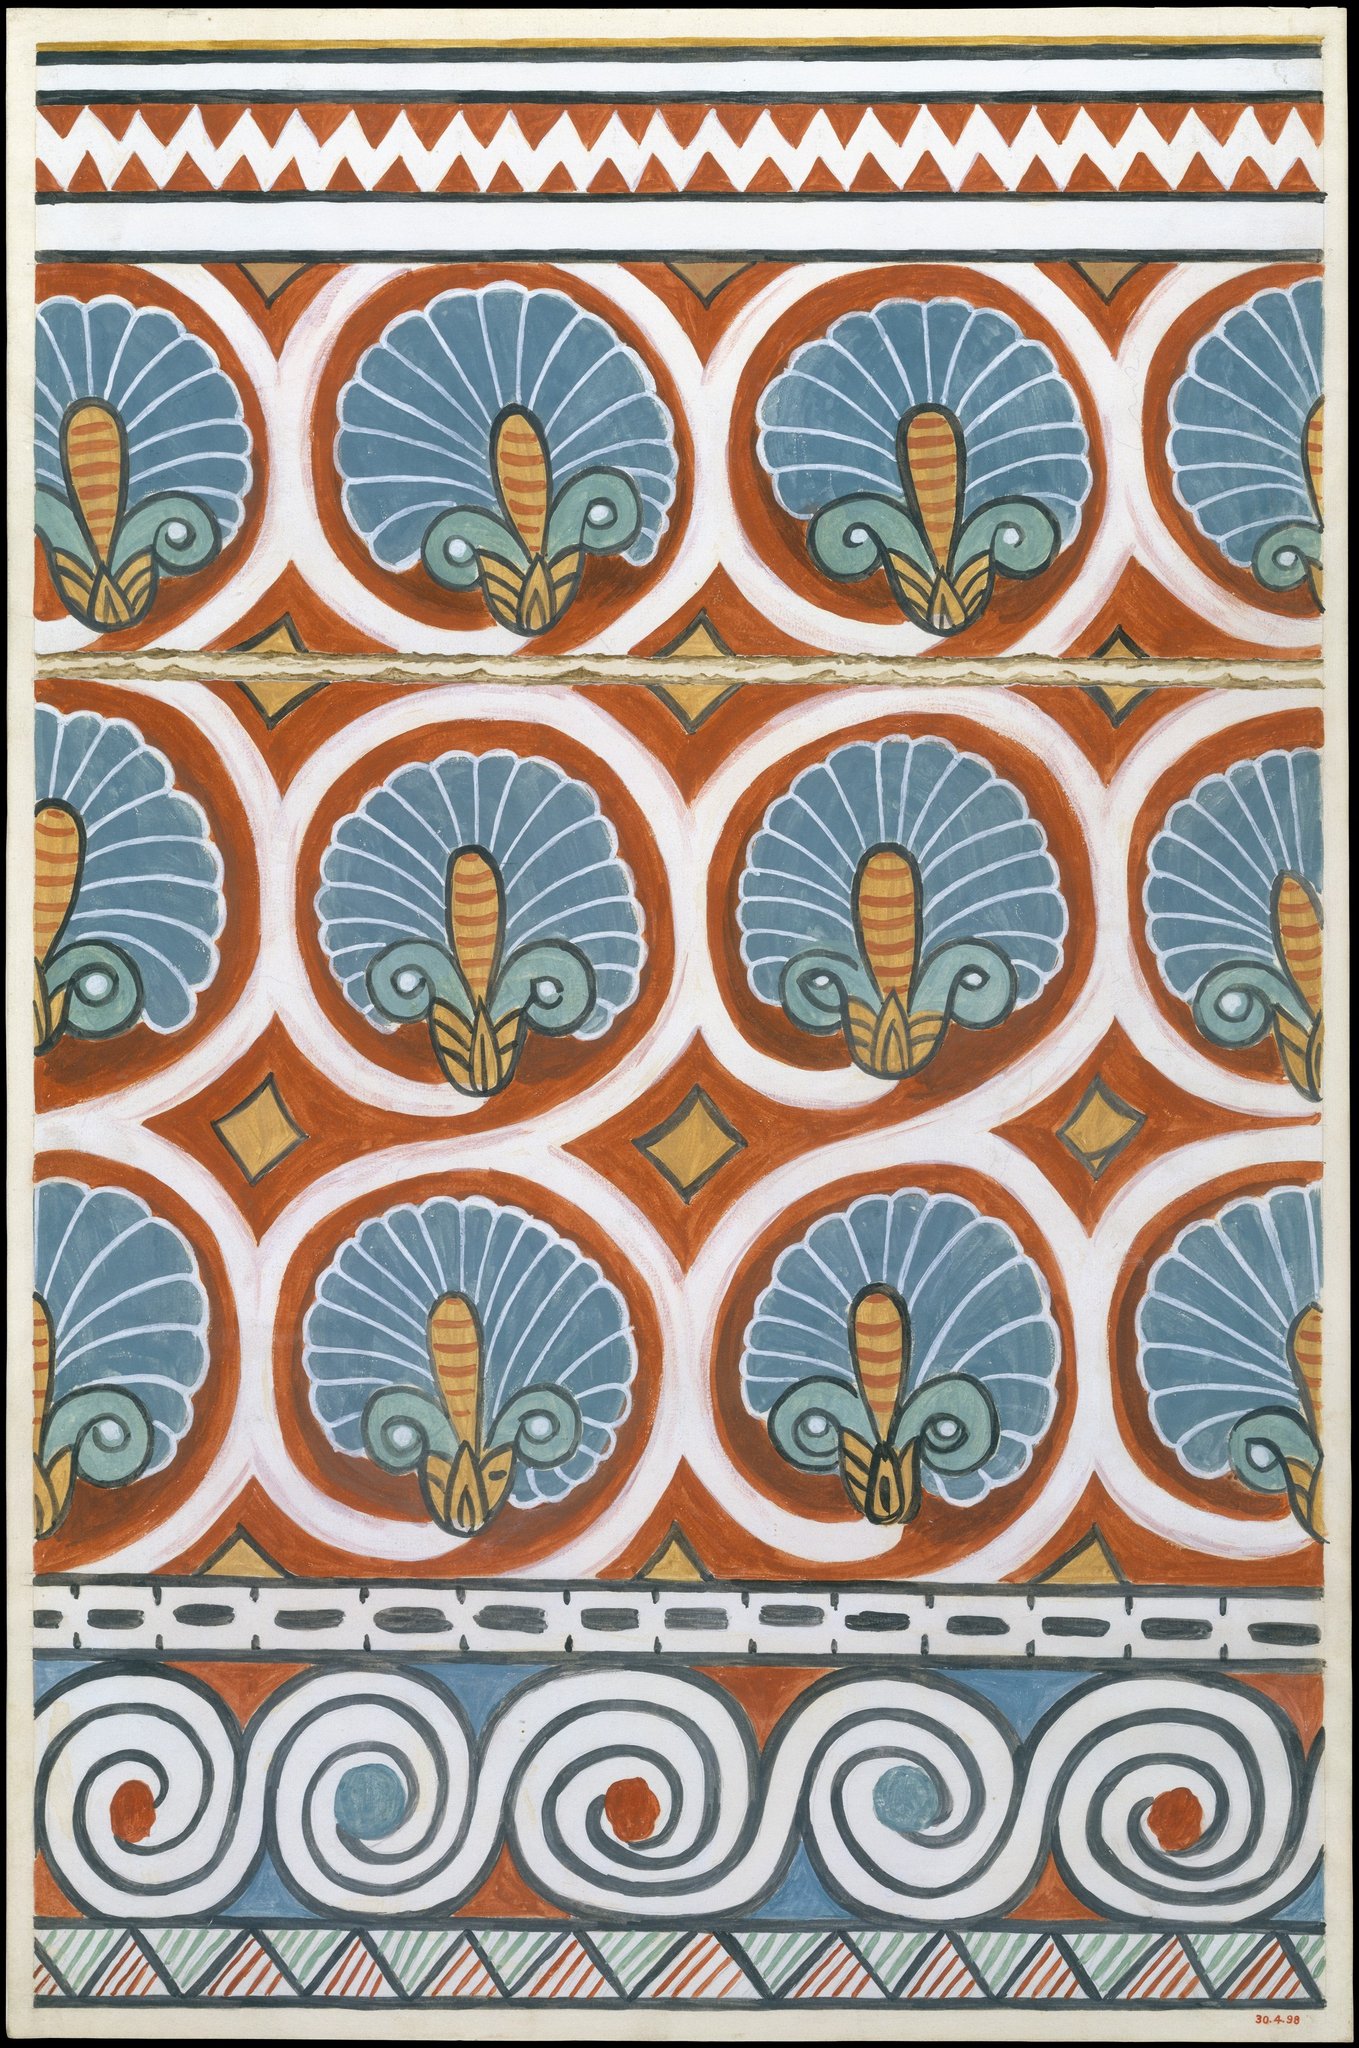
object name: facsimile, qenamun tt 162, ceiling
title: Ceiling Pattern, Tomb of Qenamun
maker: nina de garis davies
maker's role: artist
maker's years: 1881-1965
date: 1479-1400 BCE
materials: paper, paint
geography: egypt